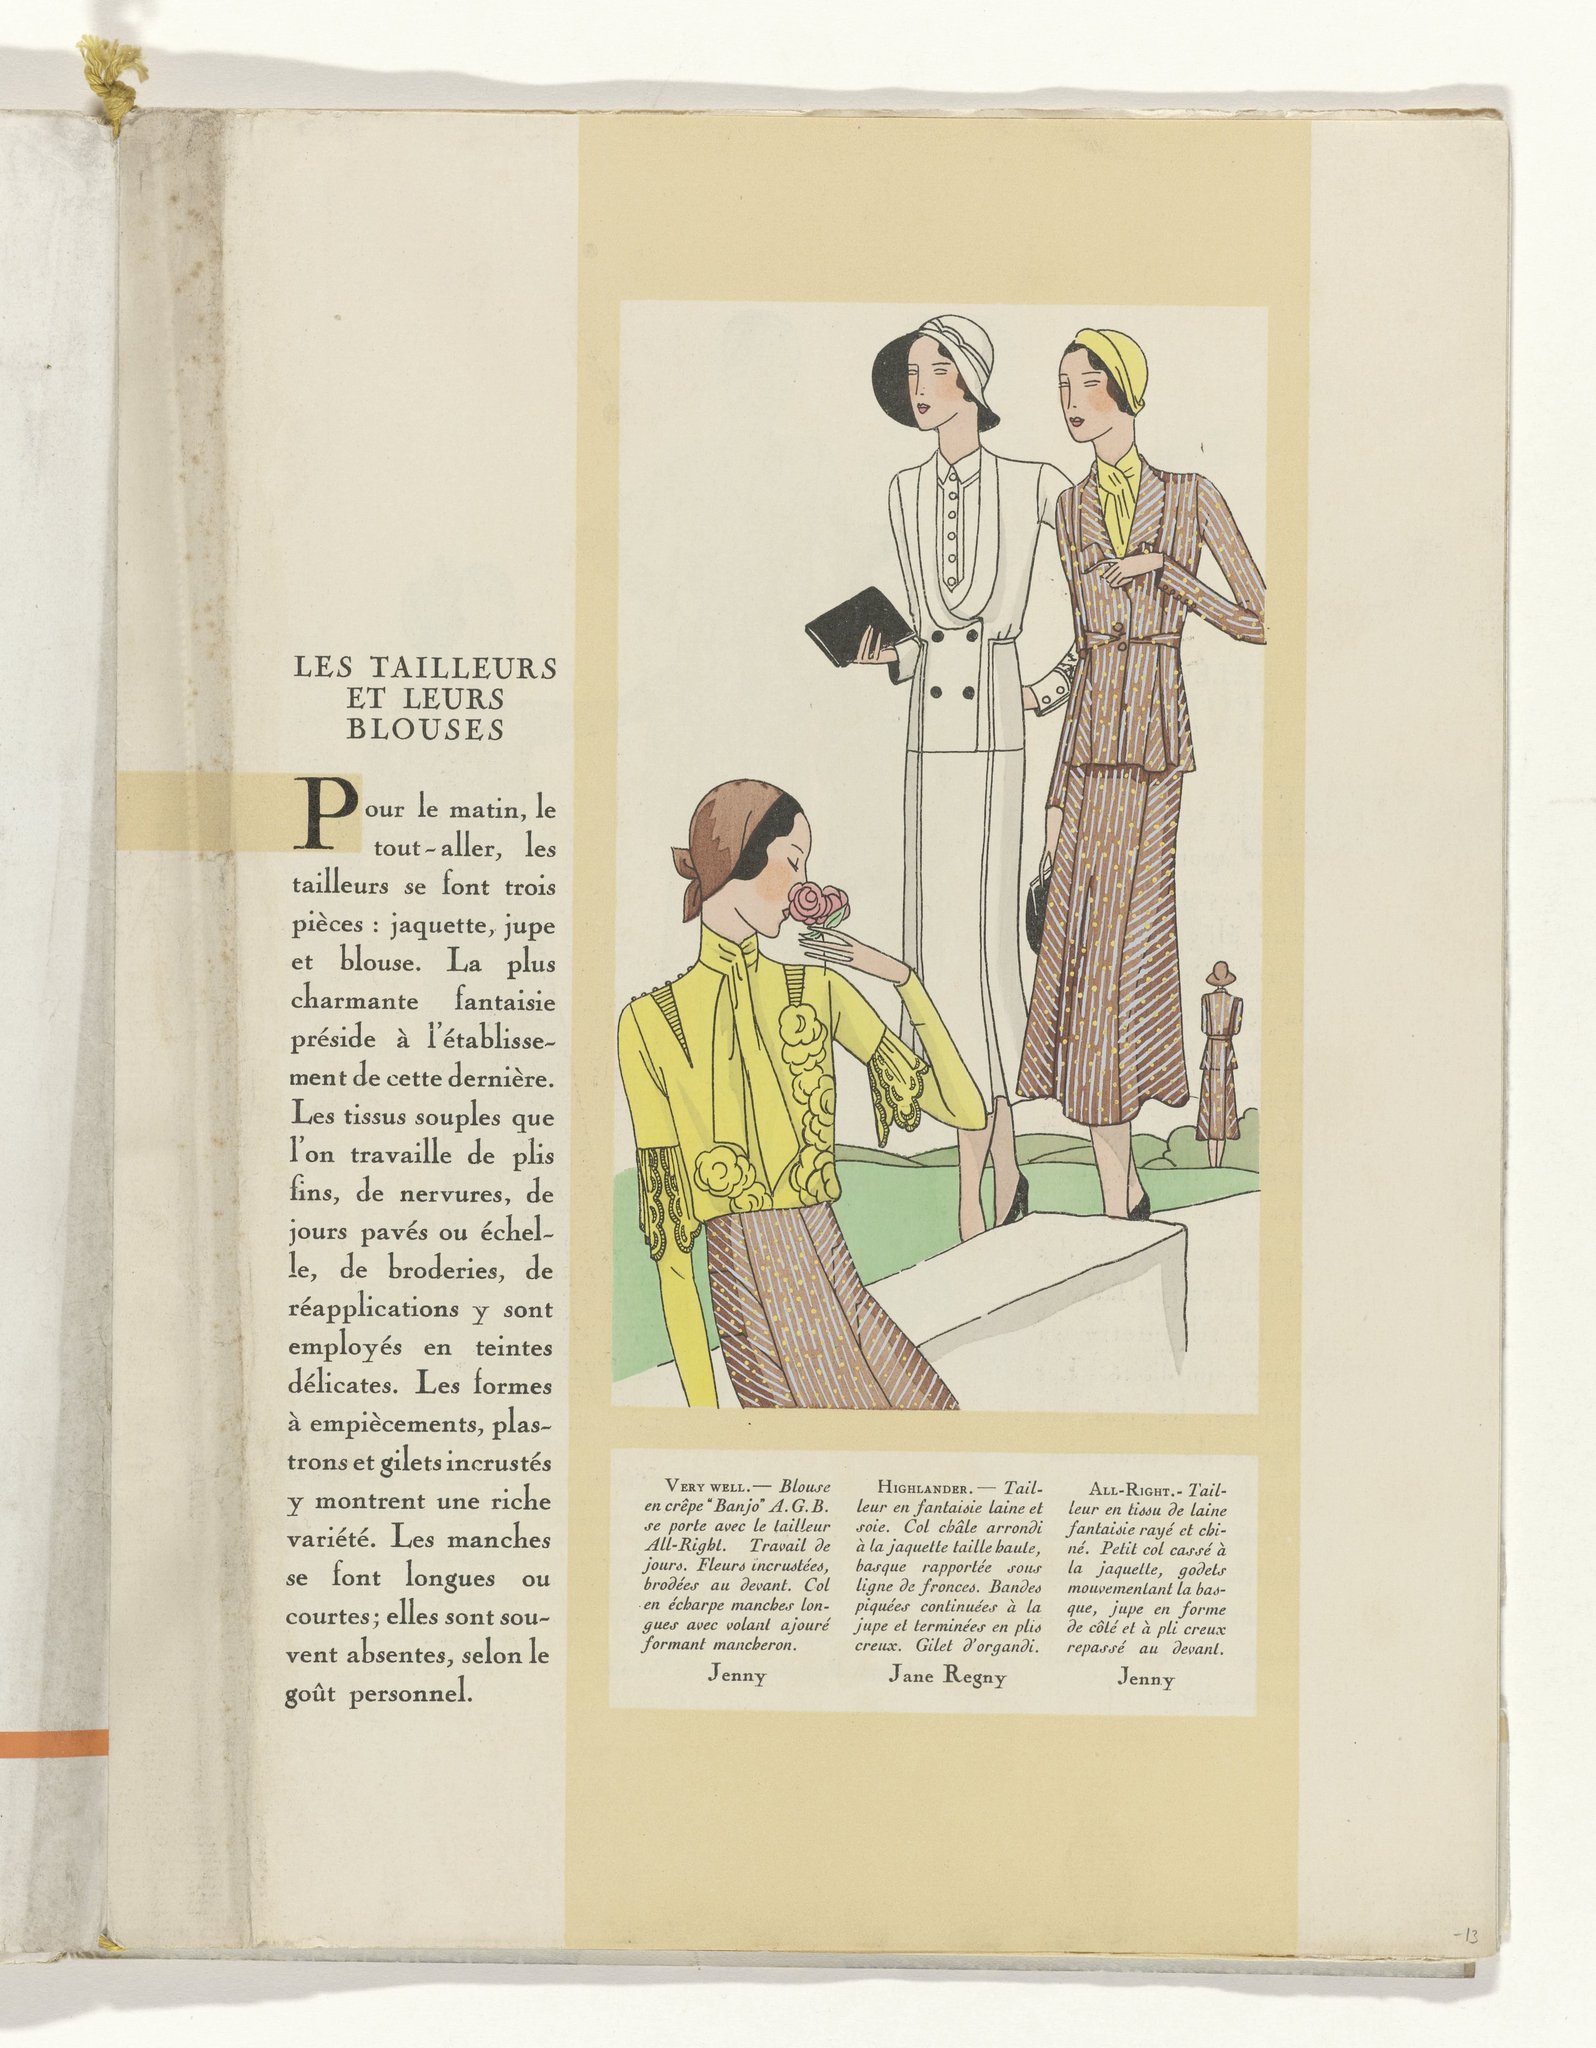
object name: magazine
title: Art - Goût - Beauté, Feuillets de l' élégance féminine, Mai 1931, No. 129, 11e Année, p. 13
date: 1931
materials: paper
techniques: hand coloring, lithograph, pochoir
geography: paris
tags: cut flowers; nosegay, bunch of flowers, clothing for the upper part of the body: blouse (+ women's clothes), ensembles of pieces of clothing (suit) (+ women's clothes), neck-gear ~ clothing (shawl collar) (+ women's clothes), clothing for the upper part of the body (vest) (+ women's clothes), fashion plates, head-gear: hat (+ women's clothes)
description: Tekst ´Les tailleurs et leurs blouses´ Links: blouse van crêpe "Banjo" A.G.B., van Jenny. Midden: 'tailleur' (mantelpak) van wol en zijde met een vest van organdi, van Jane Regny. Rechts: 'tailleur' (mantelpak) van gestreepte en gestippelde wol, van Jenny. Pagina uit het modetijdschrift Art-Goût-Beauté (1920-1933).